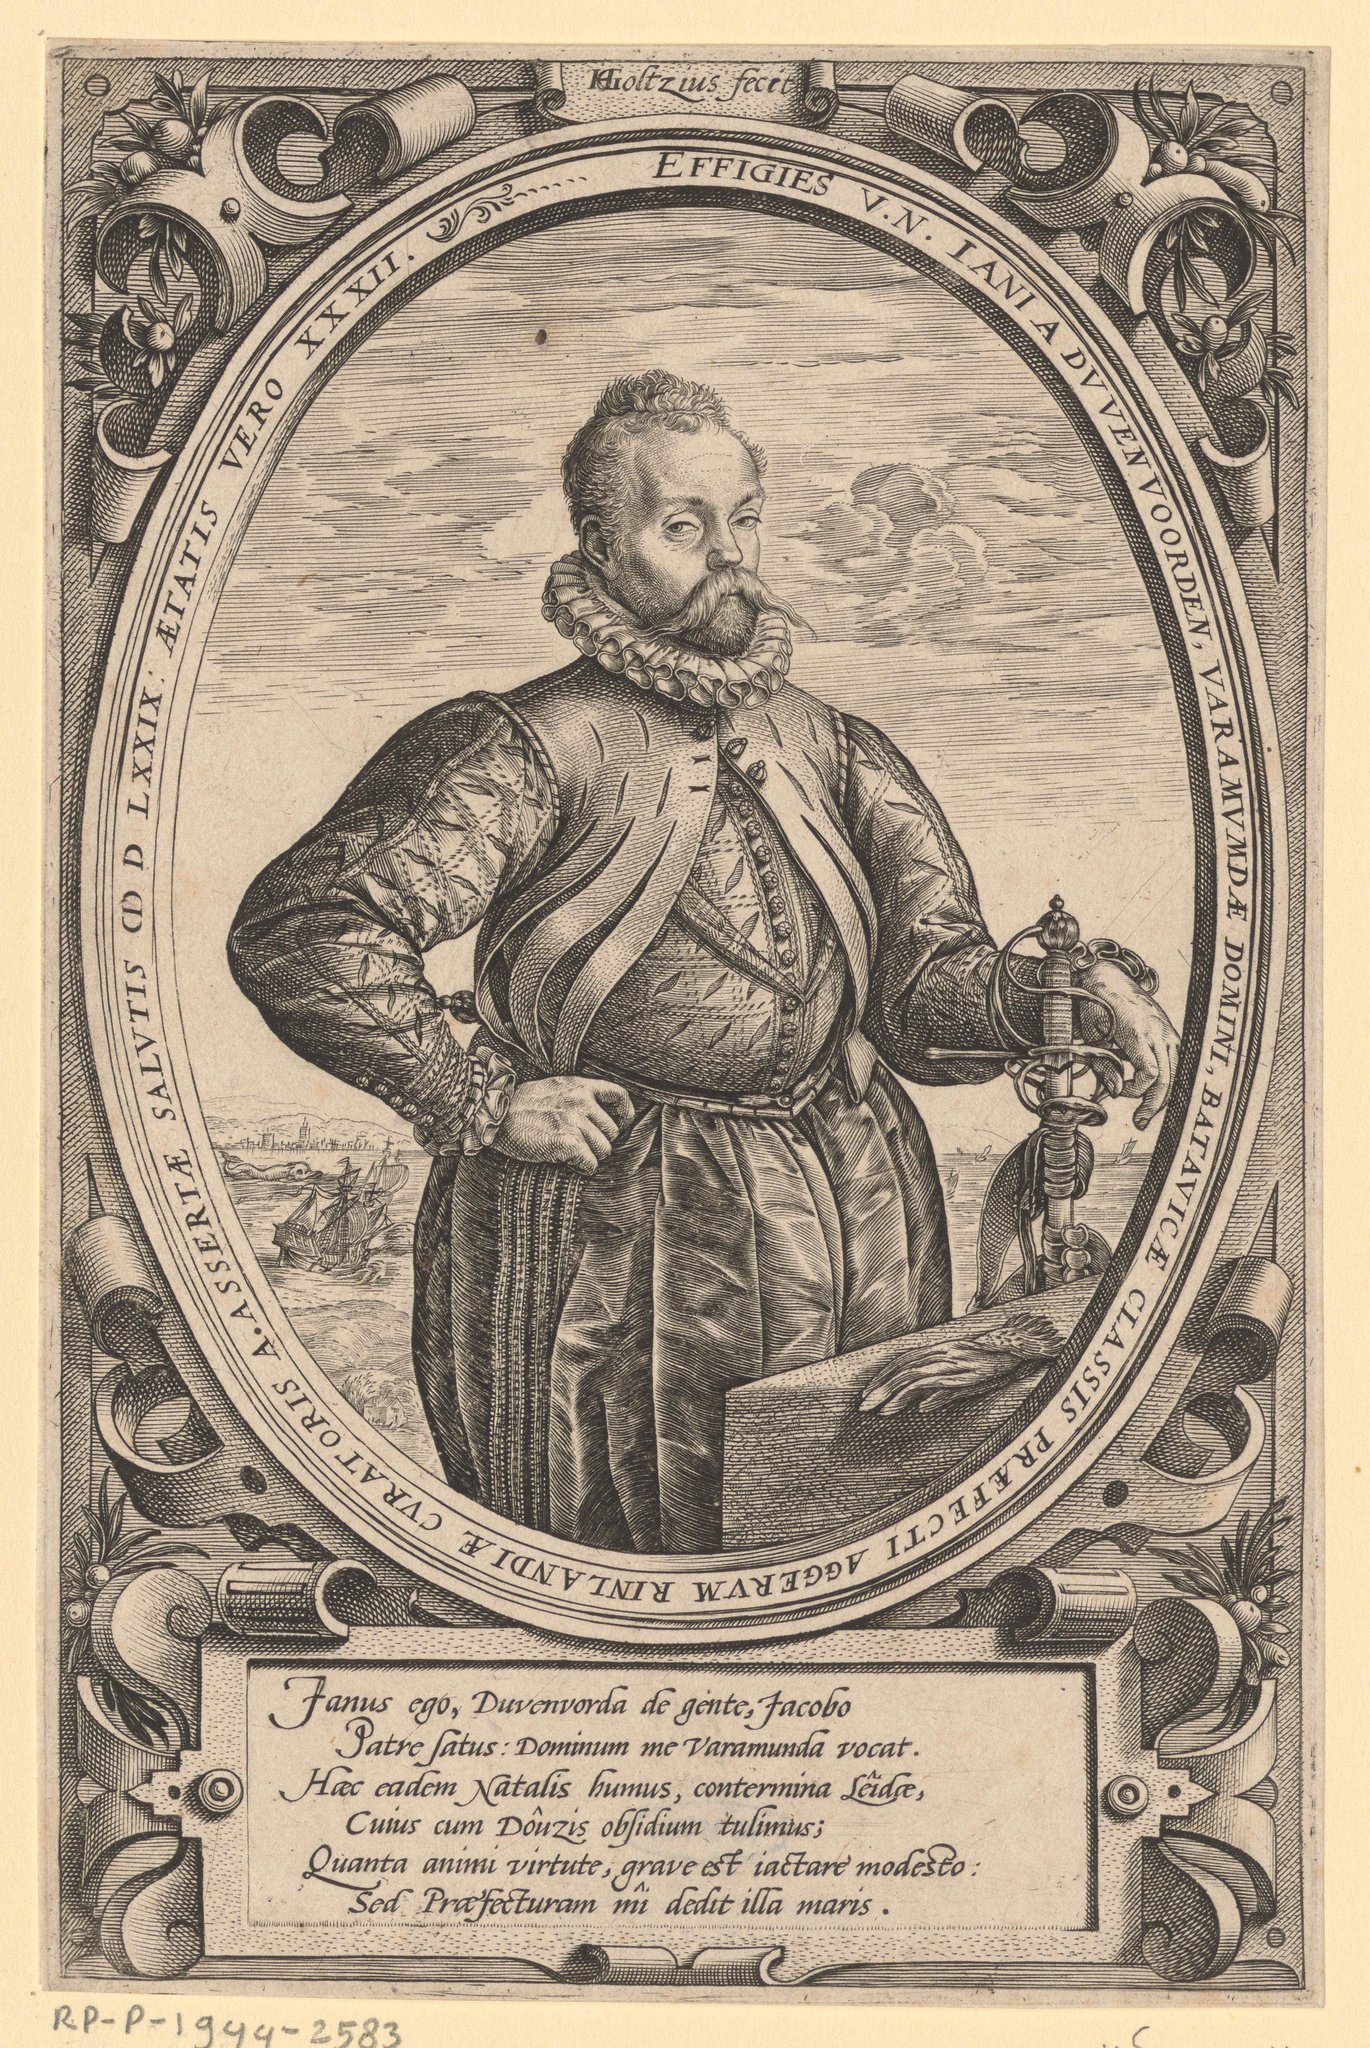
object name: print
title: Portret van Johan van Duvenvoorde op 32-jarige leeftijd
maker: hendrick goltzius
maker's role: draughtsman, painter, print maker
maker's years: 1558-1617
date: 1579-1617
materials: paper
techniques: engraving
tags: the hague, historical persons, commander-in-chief, admiral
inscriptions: collector's mark: Lugt 2228, collector's mark: Lugt 963